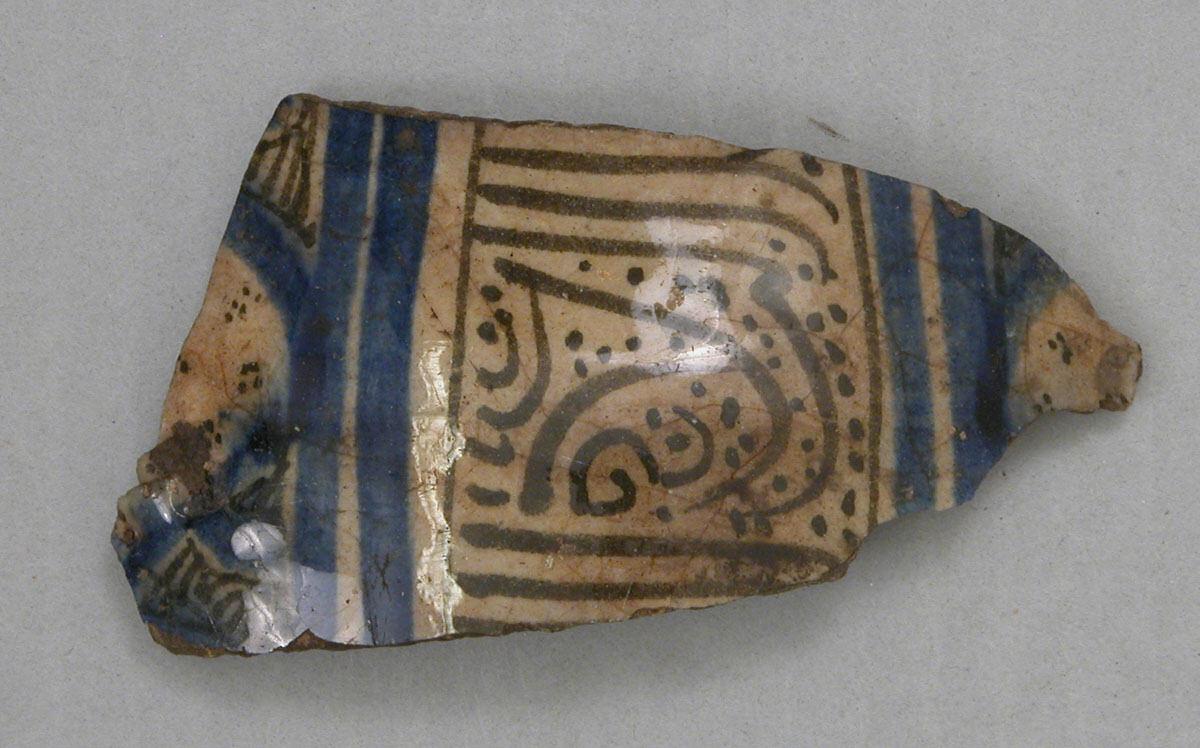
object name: fragment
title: Ceramic Fragment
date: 1301-1500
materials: glaze, stonepaste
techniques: painting, polychrome, underglaze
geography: egypt or syria